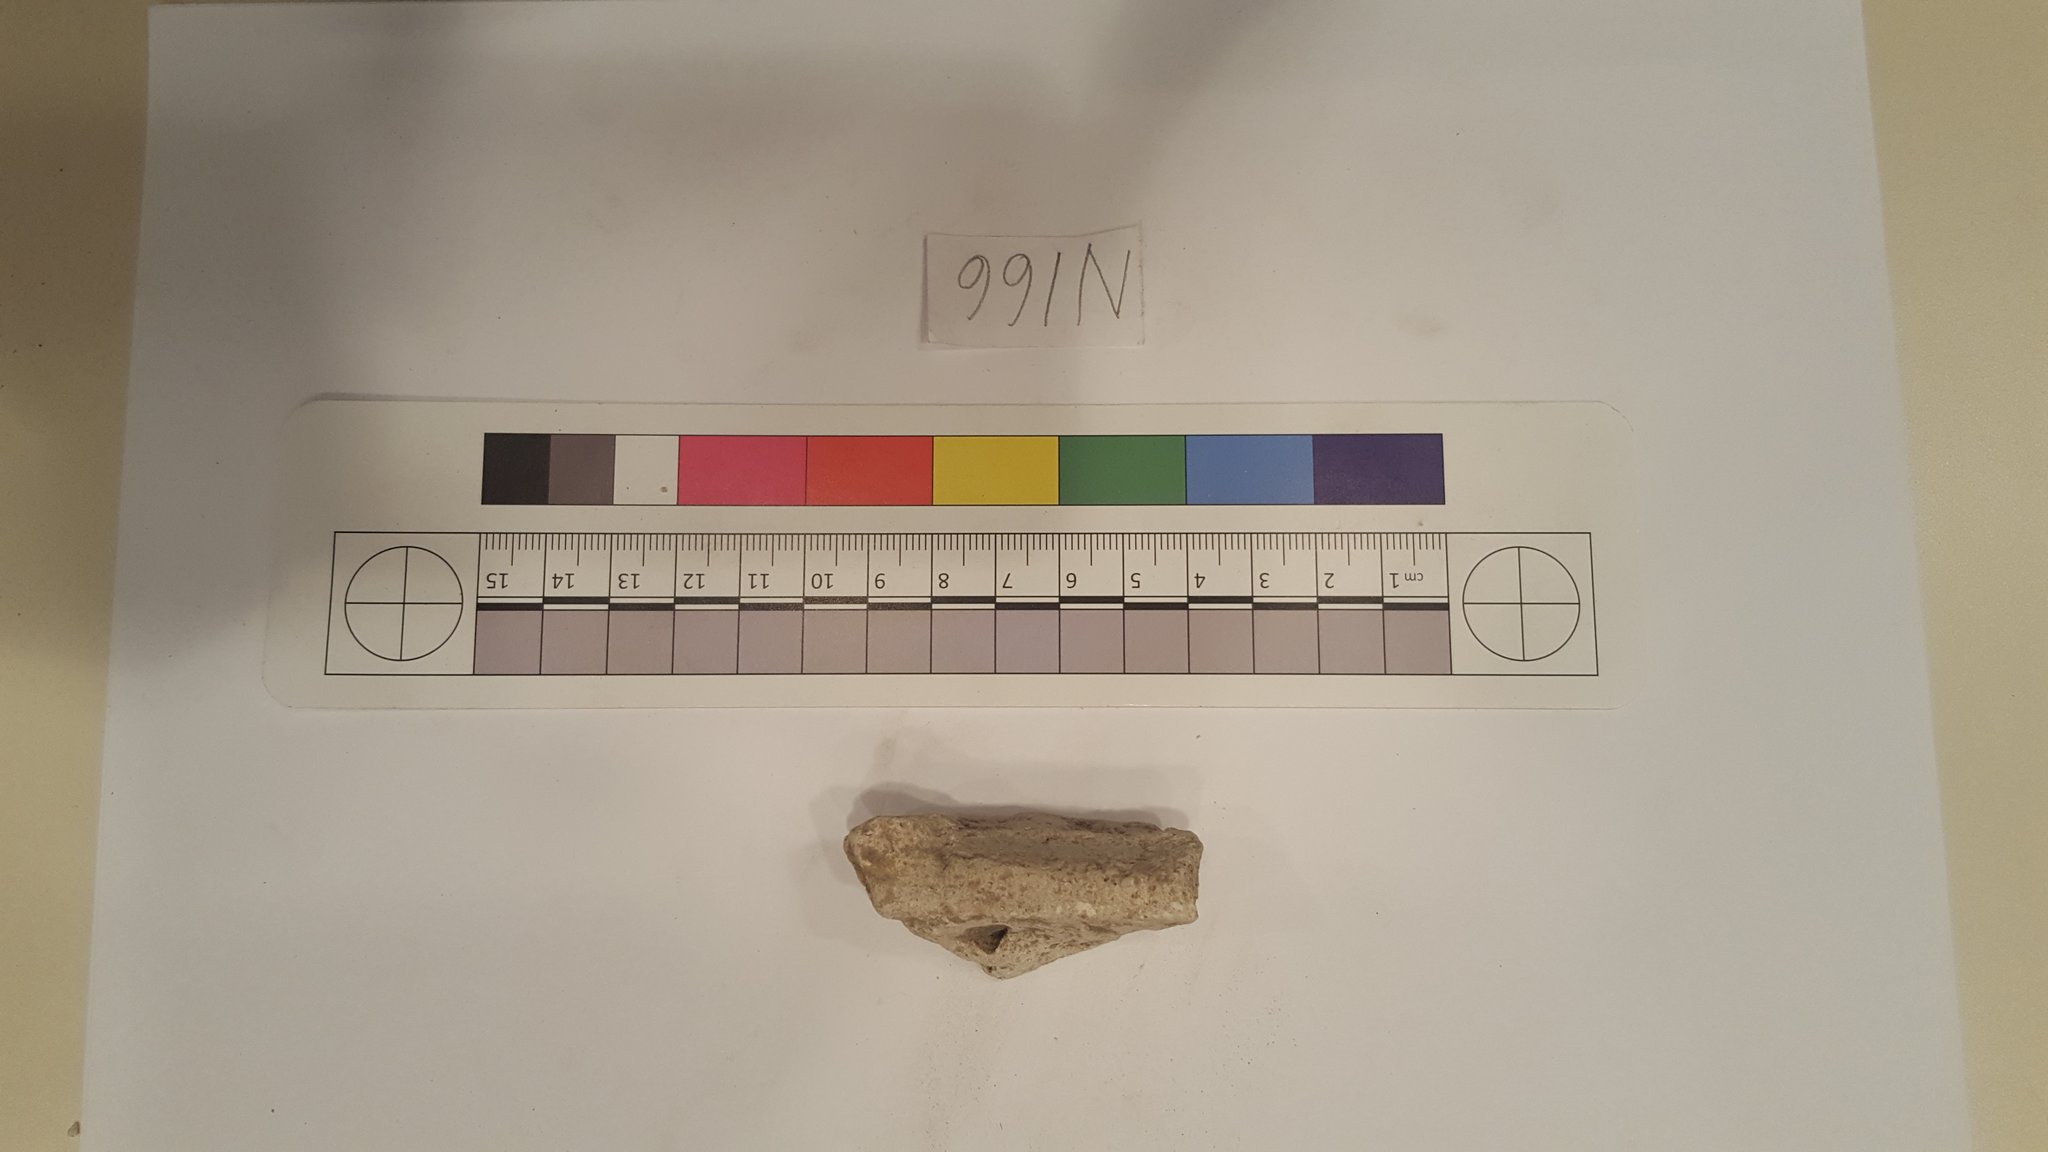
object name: fragment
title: Stucco Fragment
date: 701-1200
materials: plaster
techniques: carving, painting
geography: iran